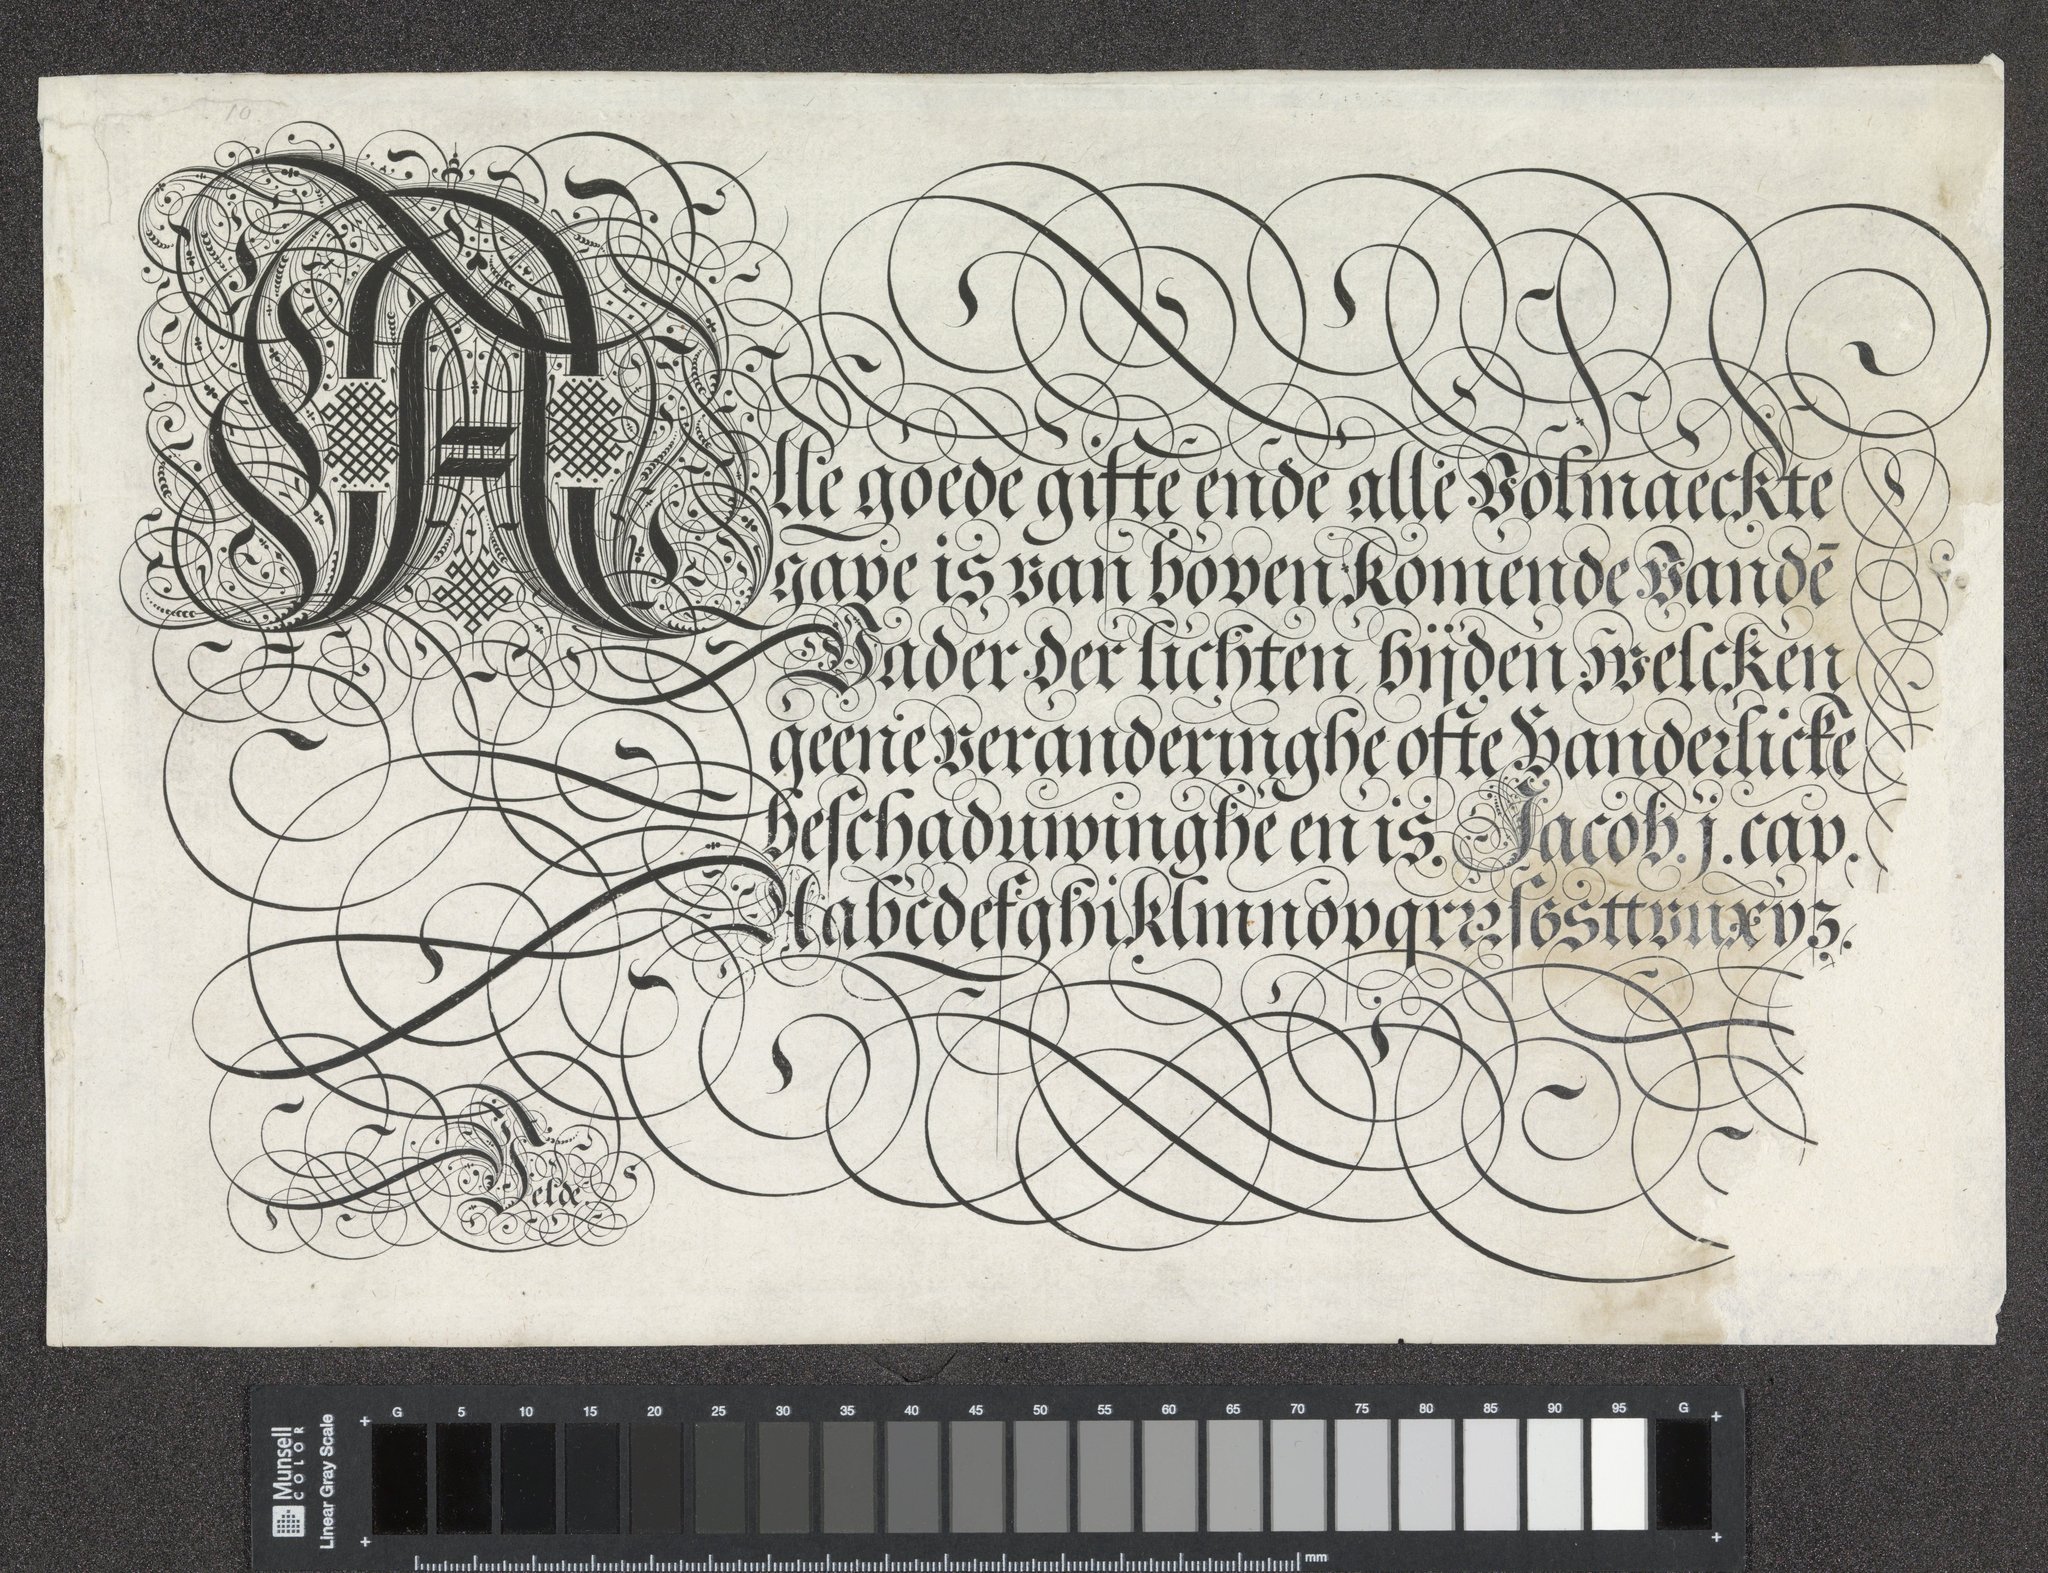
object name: print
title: Spieghel der schrijfkonste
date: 1605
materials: paper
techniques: engraving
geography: rotterdam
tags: calligraphy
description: Schrijfvoorbeeld met geornamenteerde initiaal A en zes regels tekst: Alle goede gifte ... (Jak. 1). Het voorbeeld eindigt met een onderkastalfabet in de betreffende hand. De tekst is omlijst door krulwerk. De prent maakt deel uit van een album.